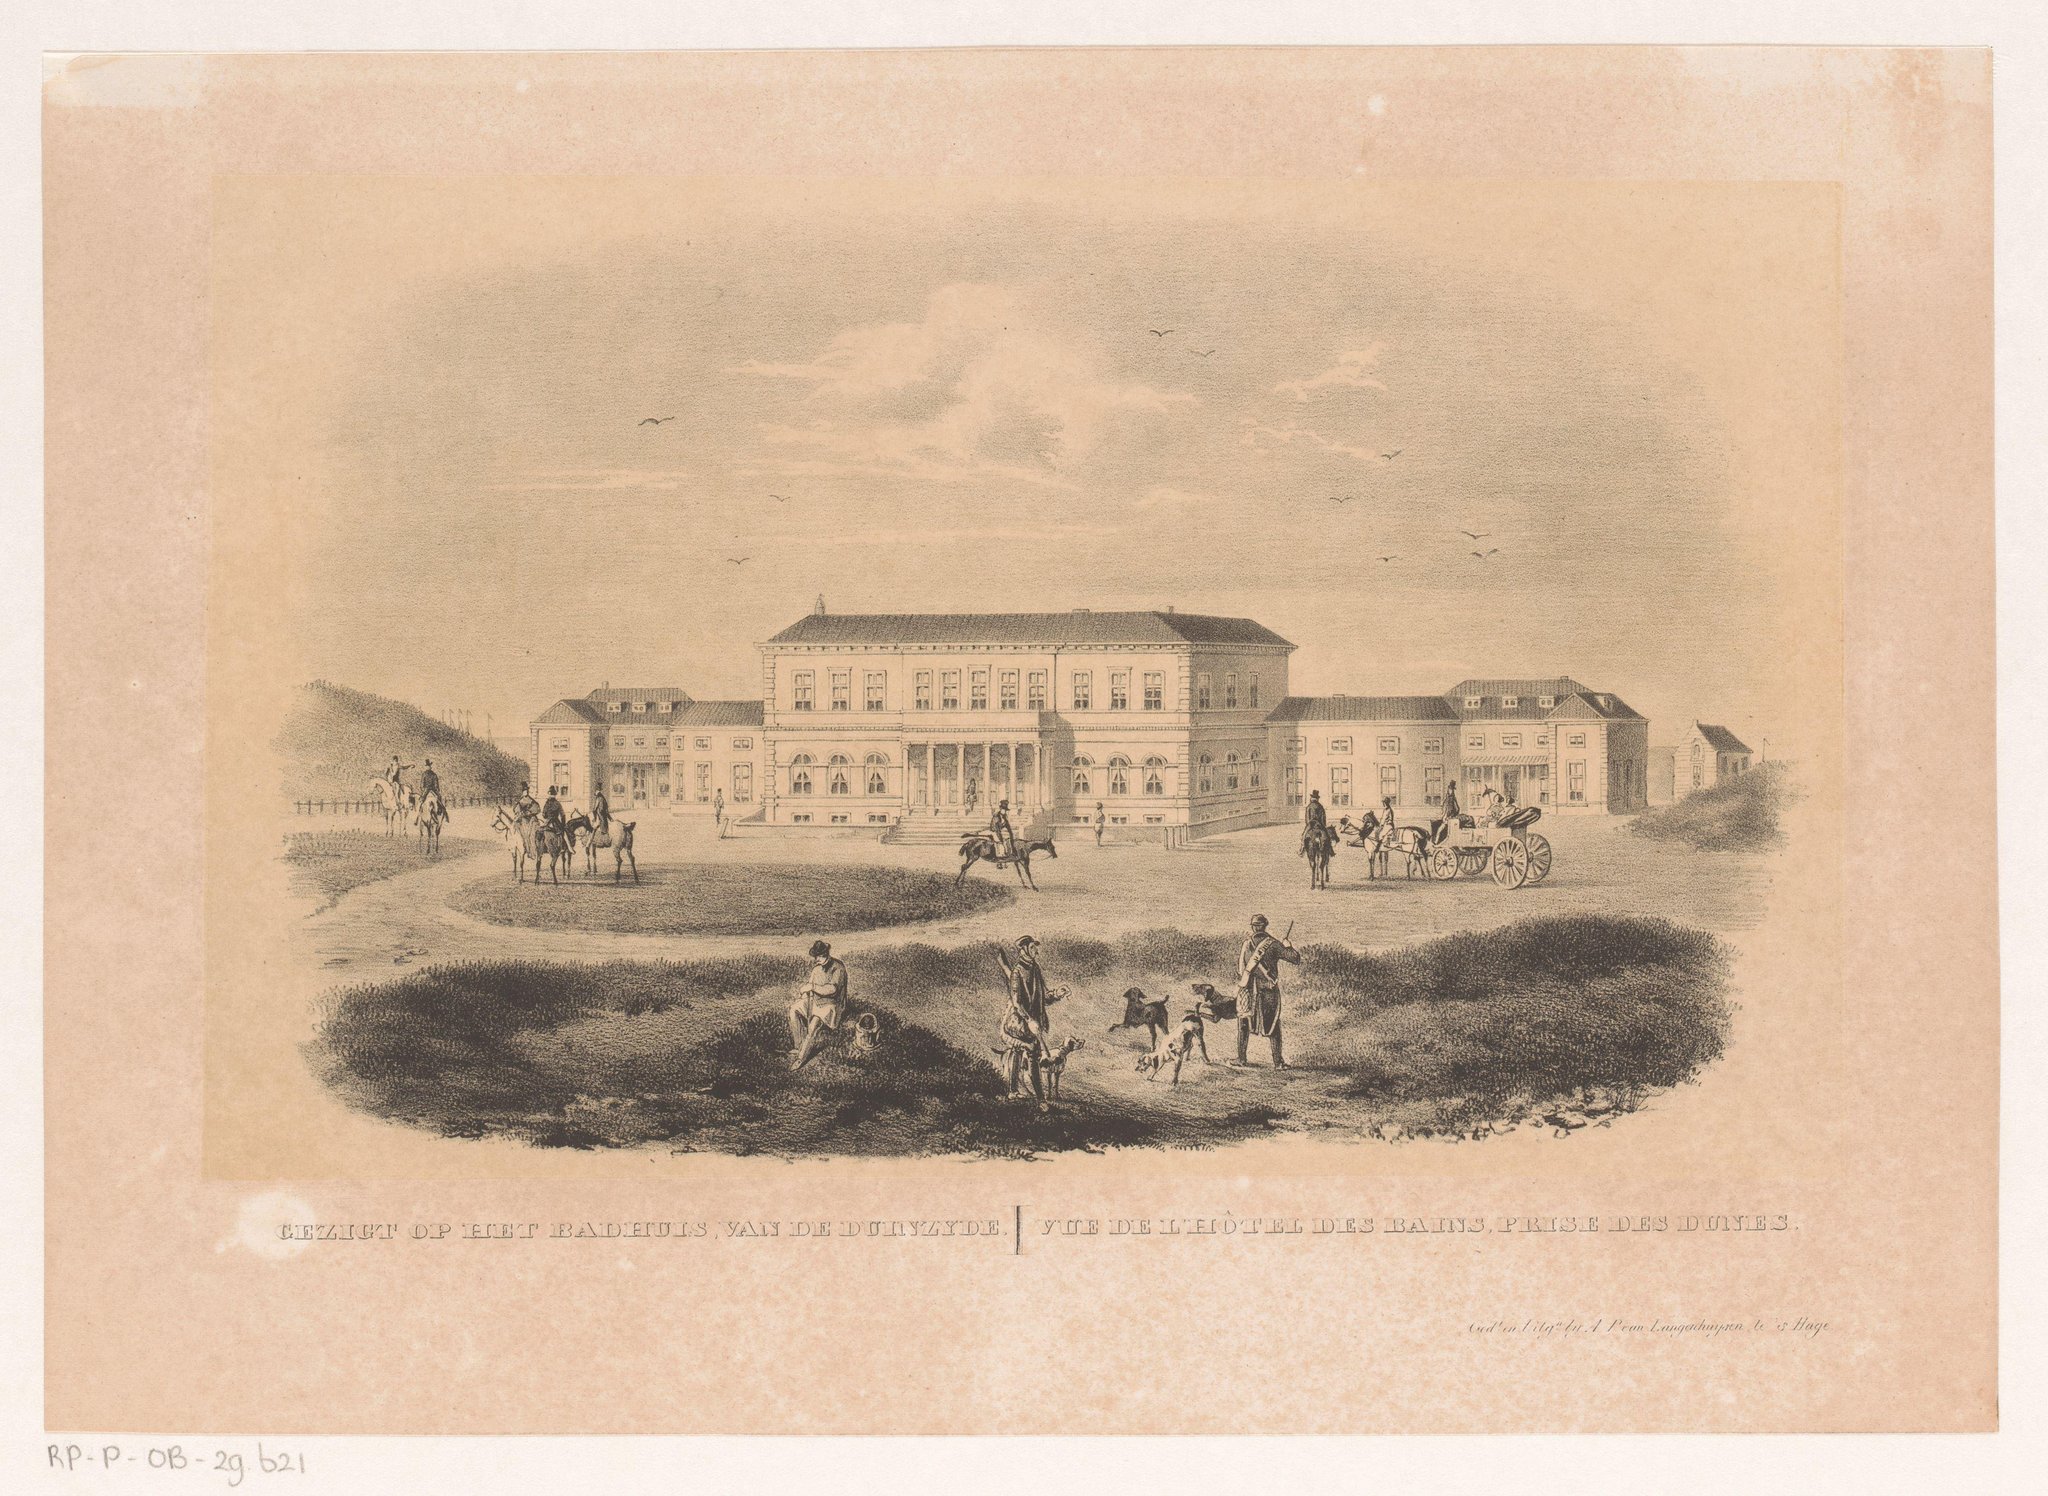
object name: print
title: Gezicht op het badhuis, van de duinzyde / Vue de l'hôtel des bains, prise des dunes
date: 1830-1846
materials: paper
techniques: tone lithography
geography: the hague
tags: public baths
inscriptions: collector's mark: Lugt 2228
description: Ruiters te paard en jagers op het plein voor het stedelijk badhuis te Scheveningen. Tegenwoordig staat hier het Kurhaus.